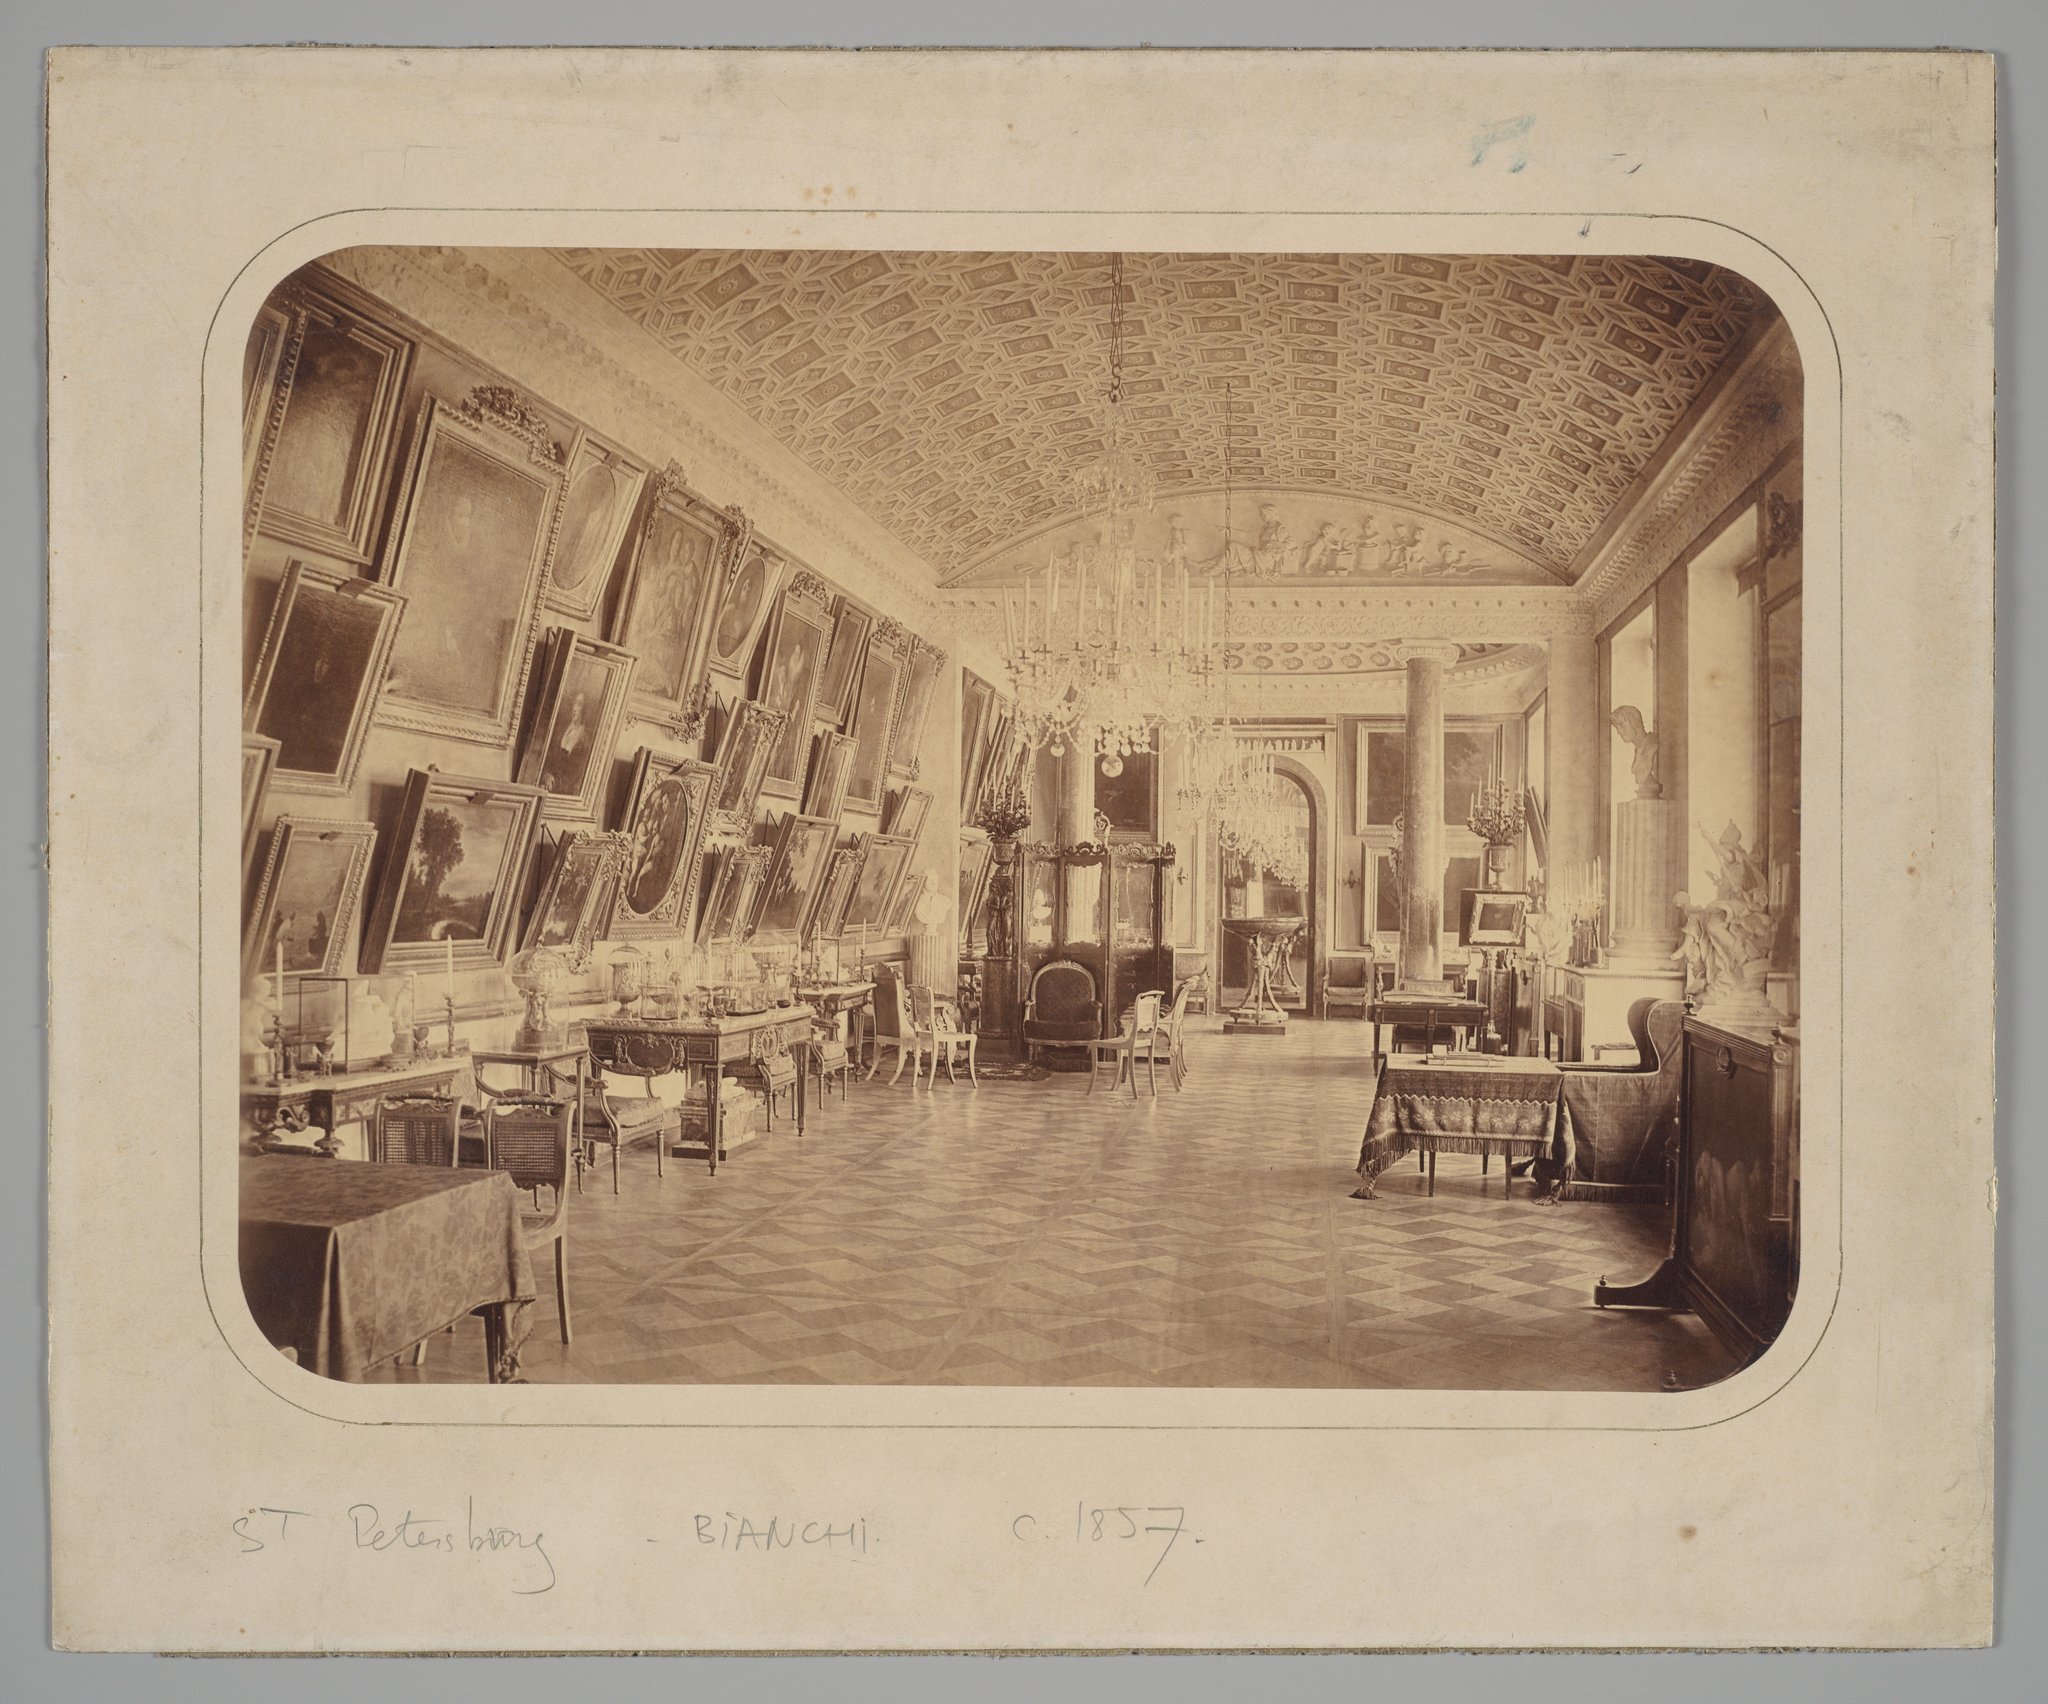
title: [Paintings Gallery, Stroganov Palace, St. Petersburg]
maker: p. bianchy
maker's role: artist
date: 1857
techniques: albumen silver print, glass negative